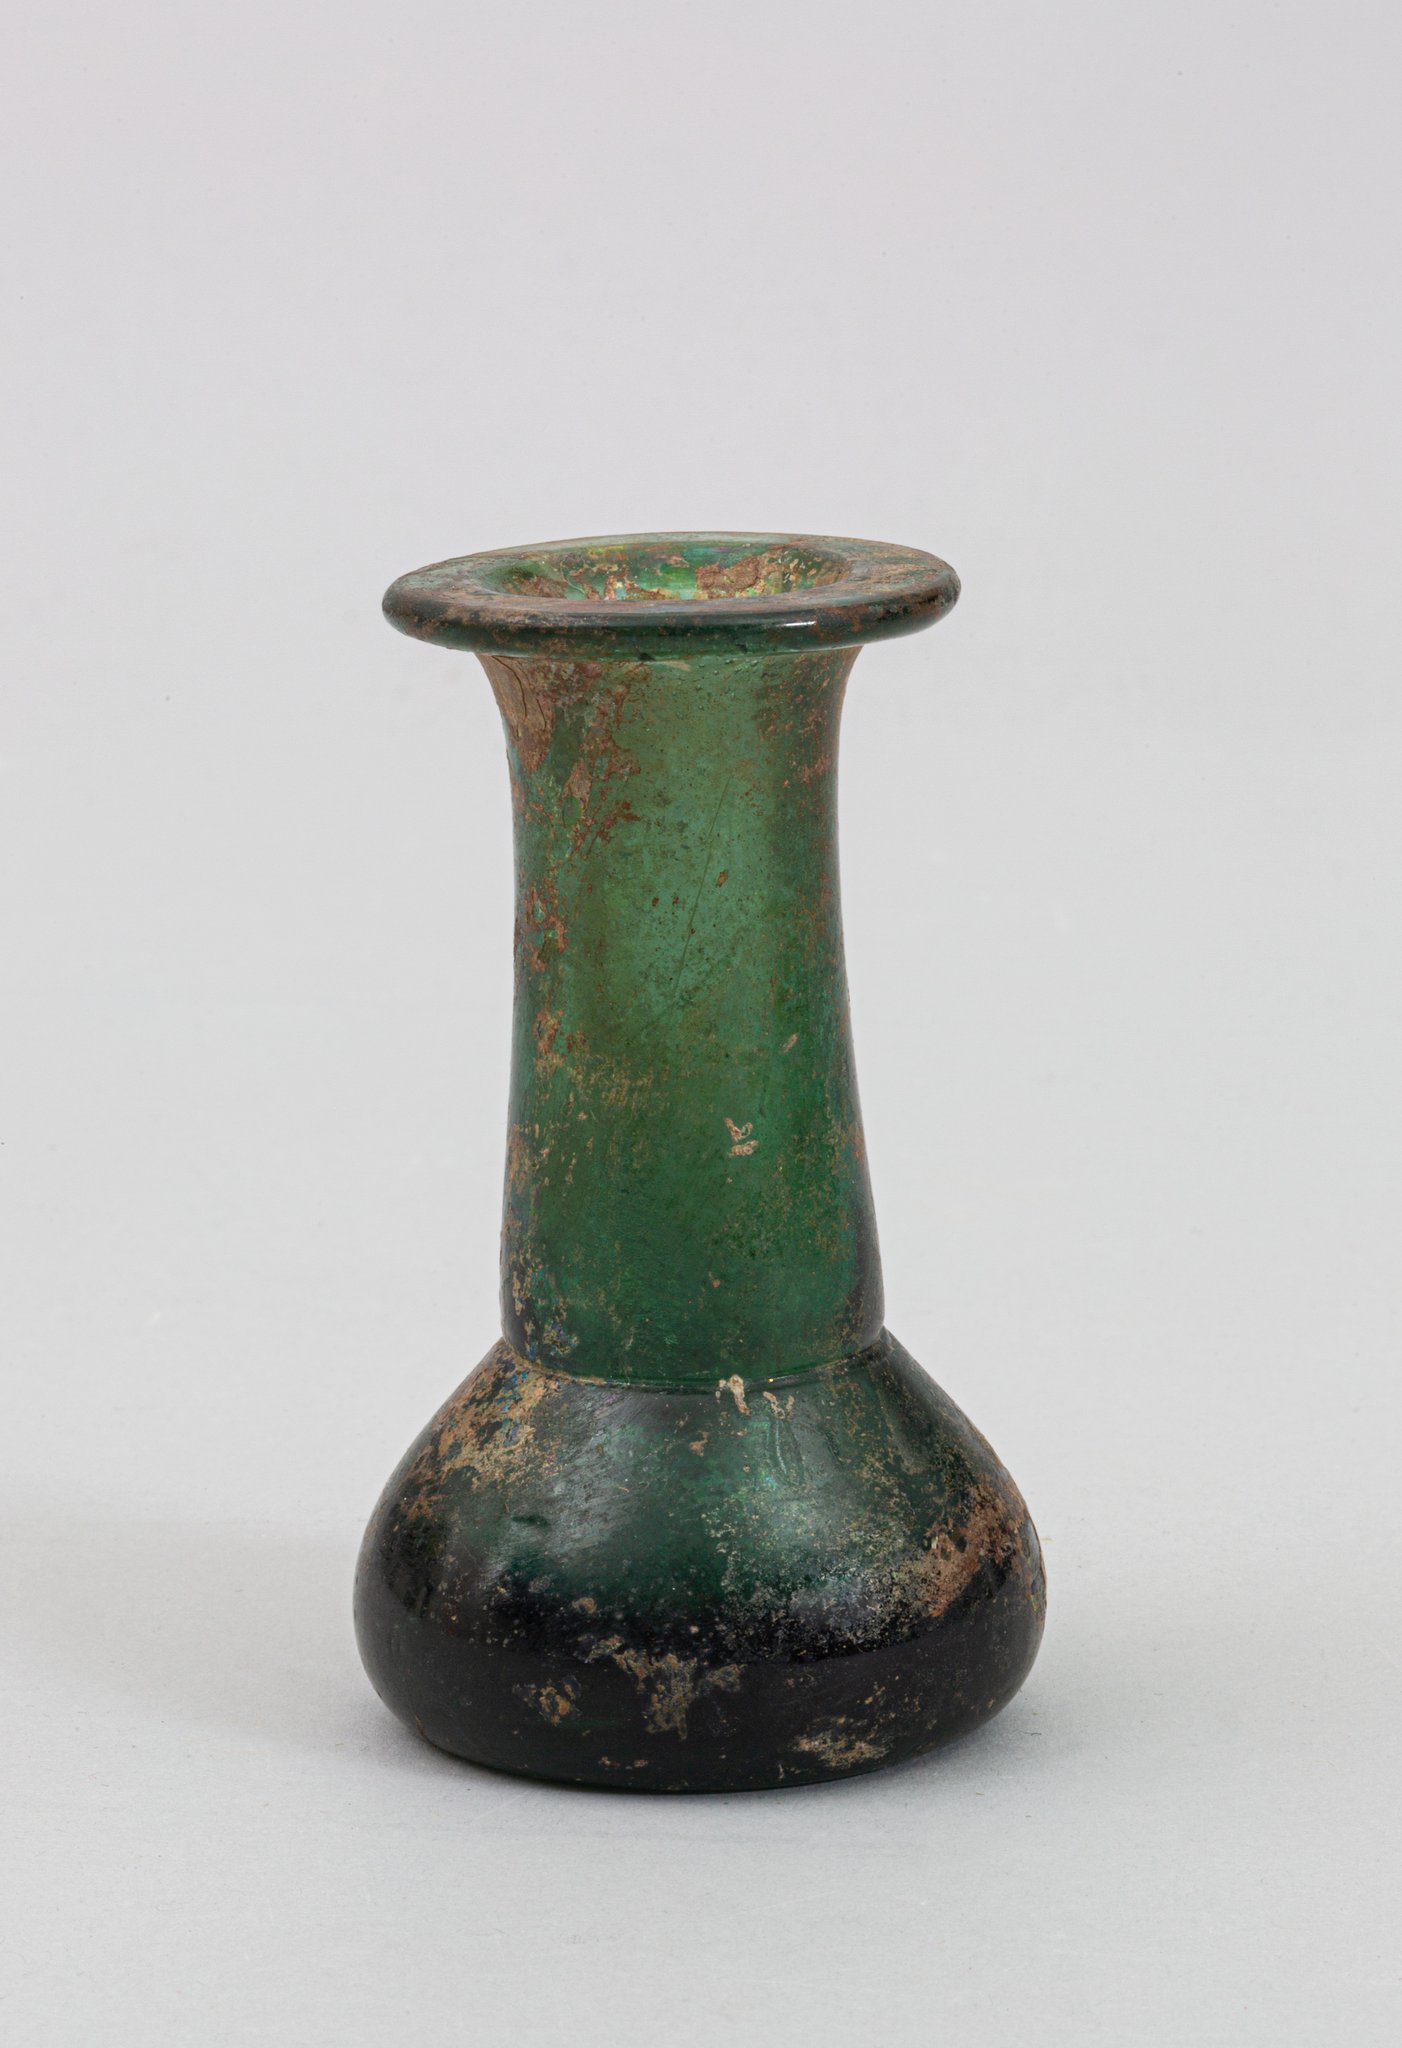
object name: perfume bottle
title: Glass perfume bottle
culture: roman, egyptian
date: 101-300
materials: glass